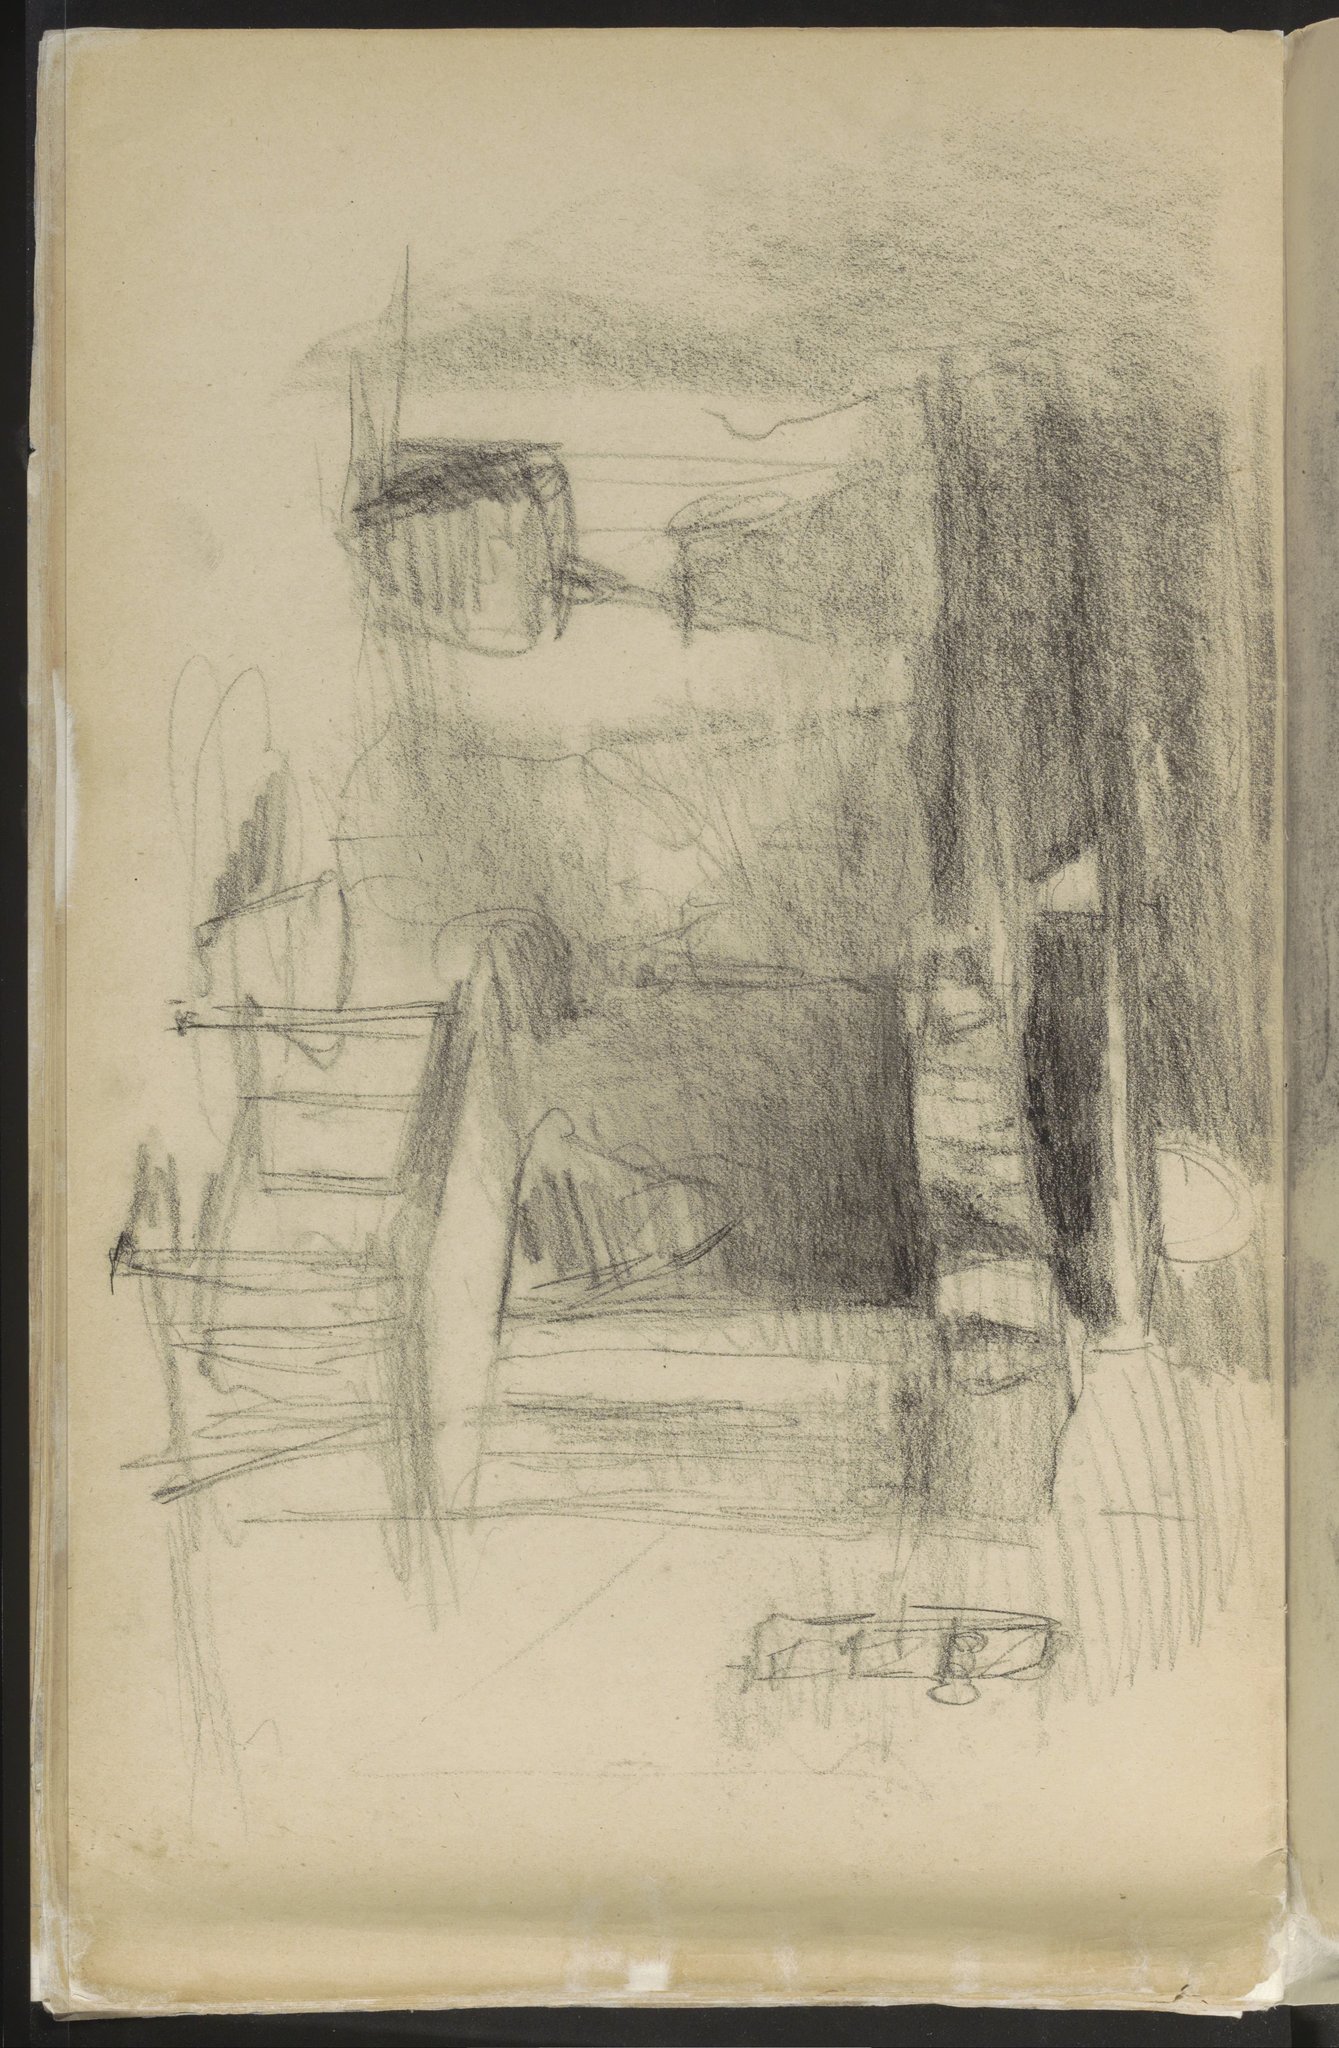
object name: sketchbook leaf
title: Boereninterieur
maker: albert neuhuys (1844-1914)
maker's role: draughtsman, painter, print maker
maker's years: 1844-1914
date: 1854-1914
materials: chalk, paper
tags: table, interior of the house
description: Blad 11 verso uit een schetsboek met 53 bladen.